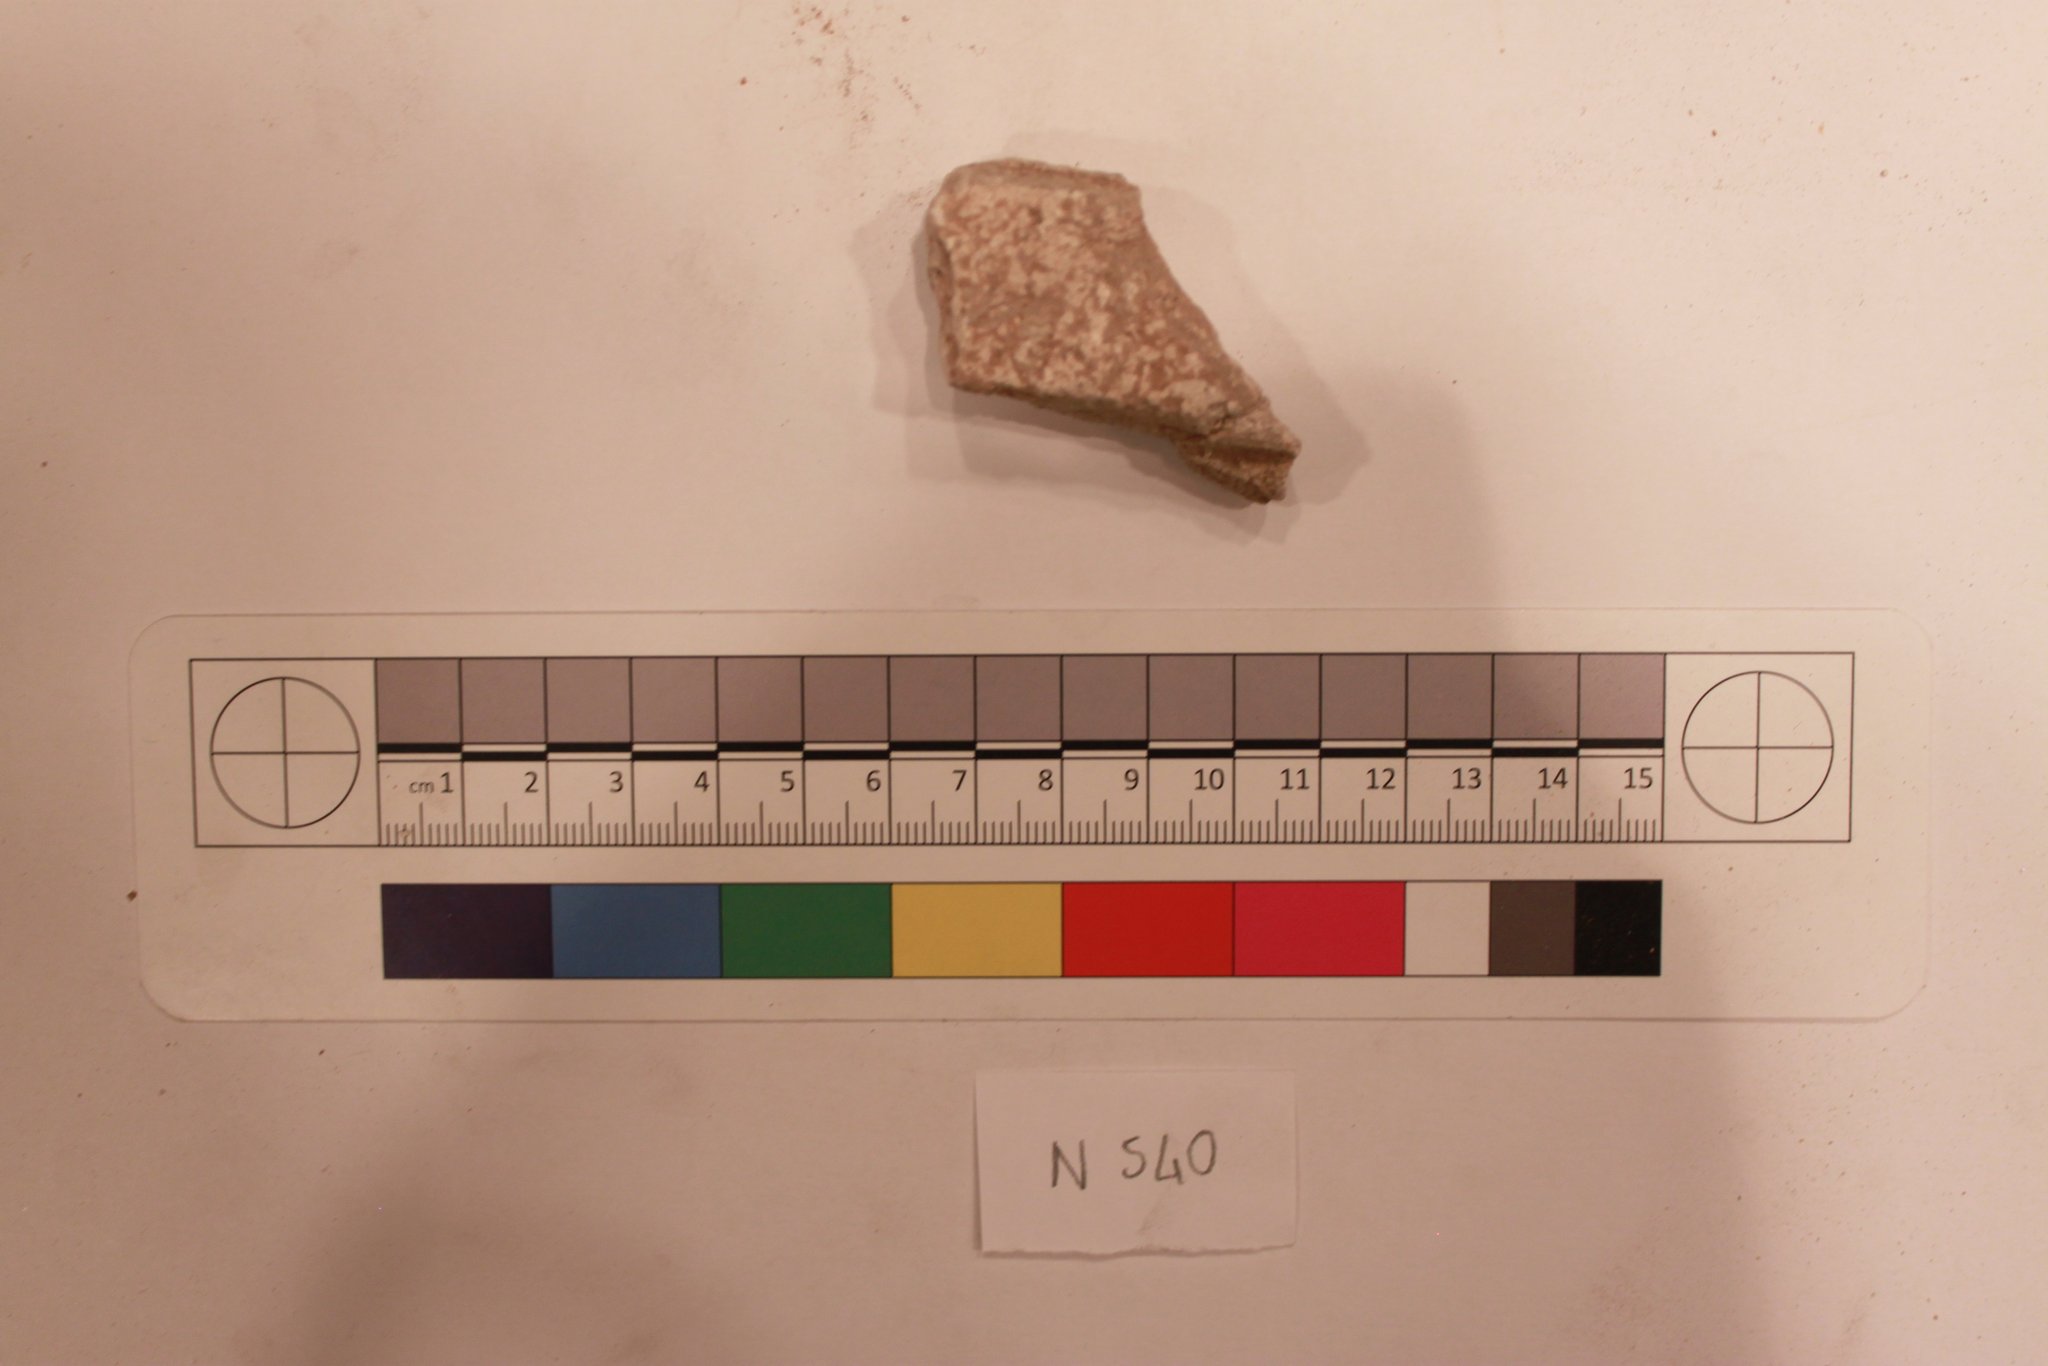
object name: fragment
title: Stucco Fragment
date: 701-1200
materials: plaster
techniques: carving, painting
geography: iran